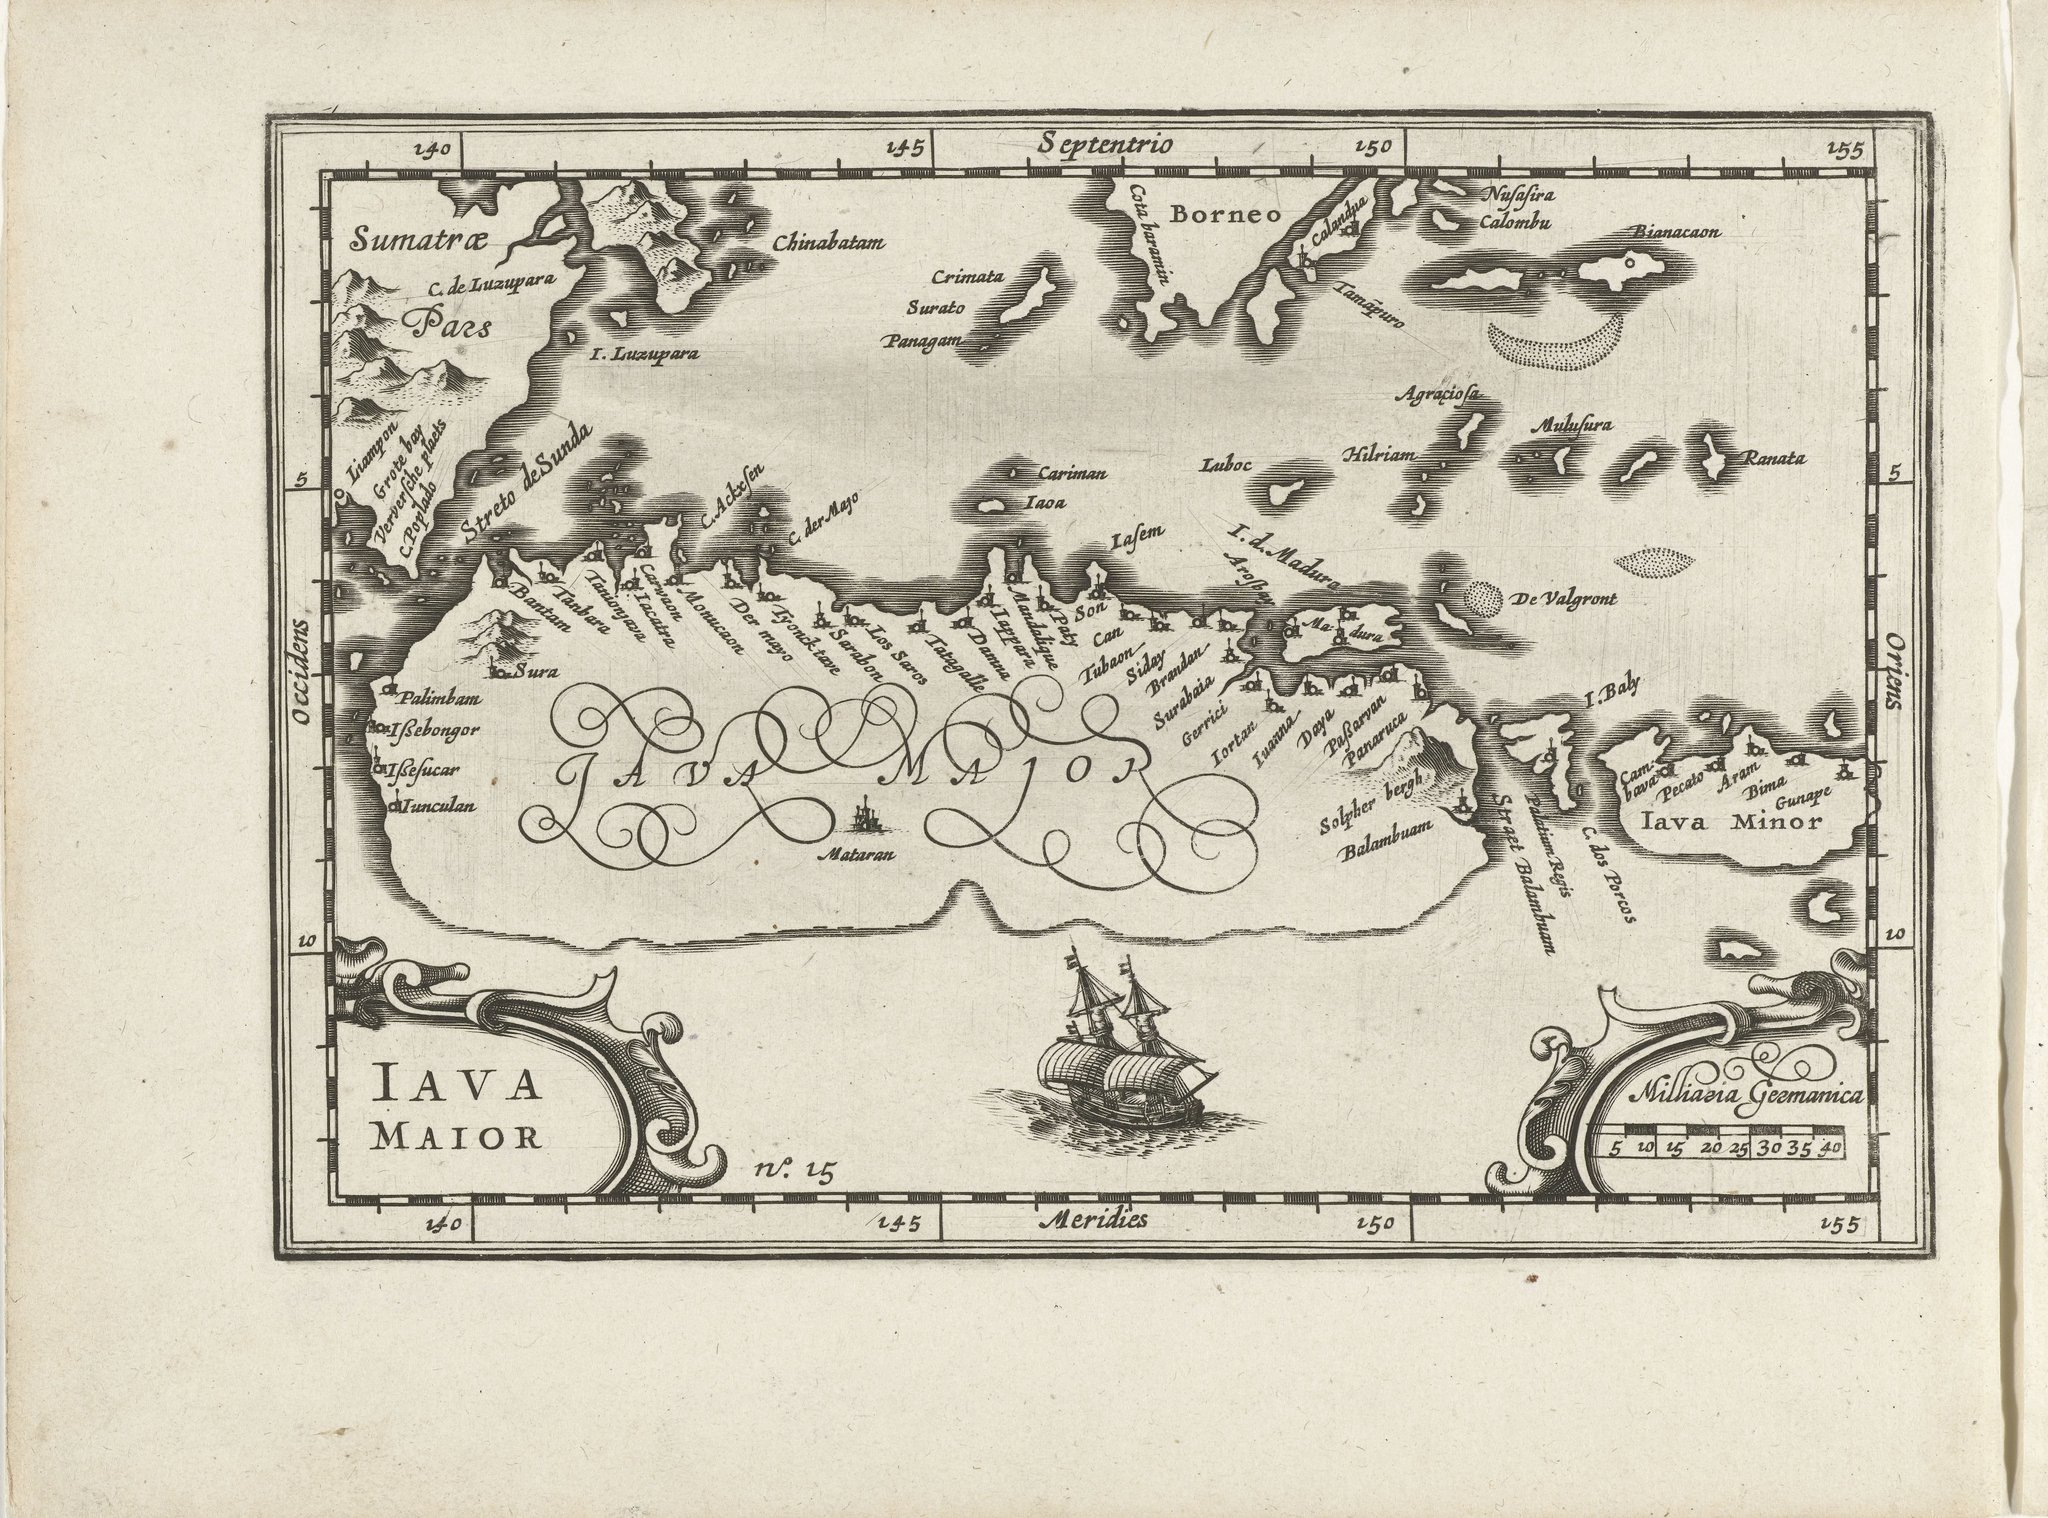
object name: map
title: Iava Maior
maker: Anonymous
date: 1646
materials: paper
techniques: engraving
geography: northern netherlands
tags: gouda, maps of separate countries or regions, landscapes in tropical and sub-tropical regions, exploration, expedition, voyage of discovery, java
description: Niet gebruikt als illustratie in: Willem Lodewijcksz, D'eerste boeck. Historie van Indien, waer inne verhaelt is de avontueren die de Hollandtsche schepen bejeghent zijn, Cornelis Claes, Amsterdam 1598. In deze opgewerkte staat gebruikt in: De Eerste Schipvaerd der Hollandsche Natie naer Oost-Indien, waer inne verhaelt wordt al wat haer sonderlings onder wegen bejegent is ... ghetrocken uyt verscheyden Iournalen ofte dagh-registers daer van ghemaeckt, zeer vermaeckelijck ende nut om lesen. Opgenomen in: I. Commelin, Begin ende voortgangh, van de Vereenighde Nederlantsche Geoctroyeerde Oost-Indische Compagnie, J. Janssonius, Amsterdam 1646. Genummerd: 15.